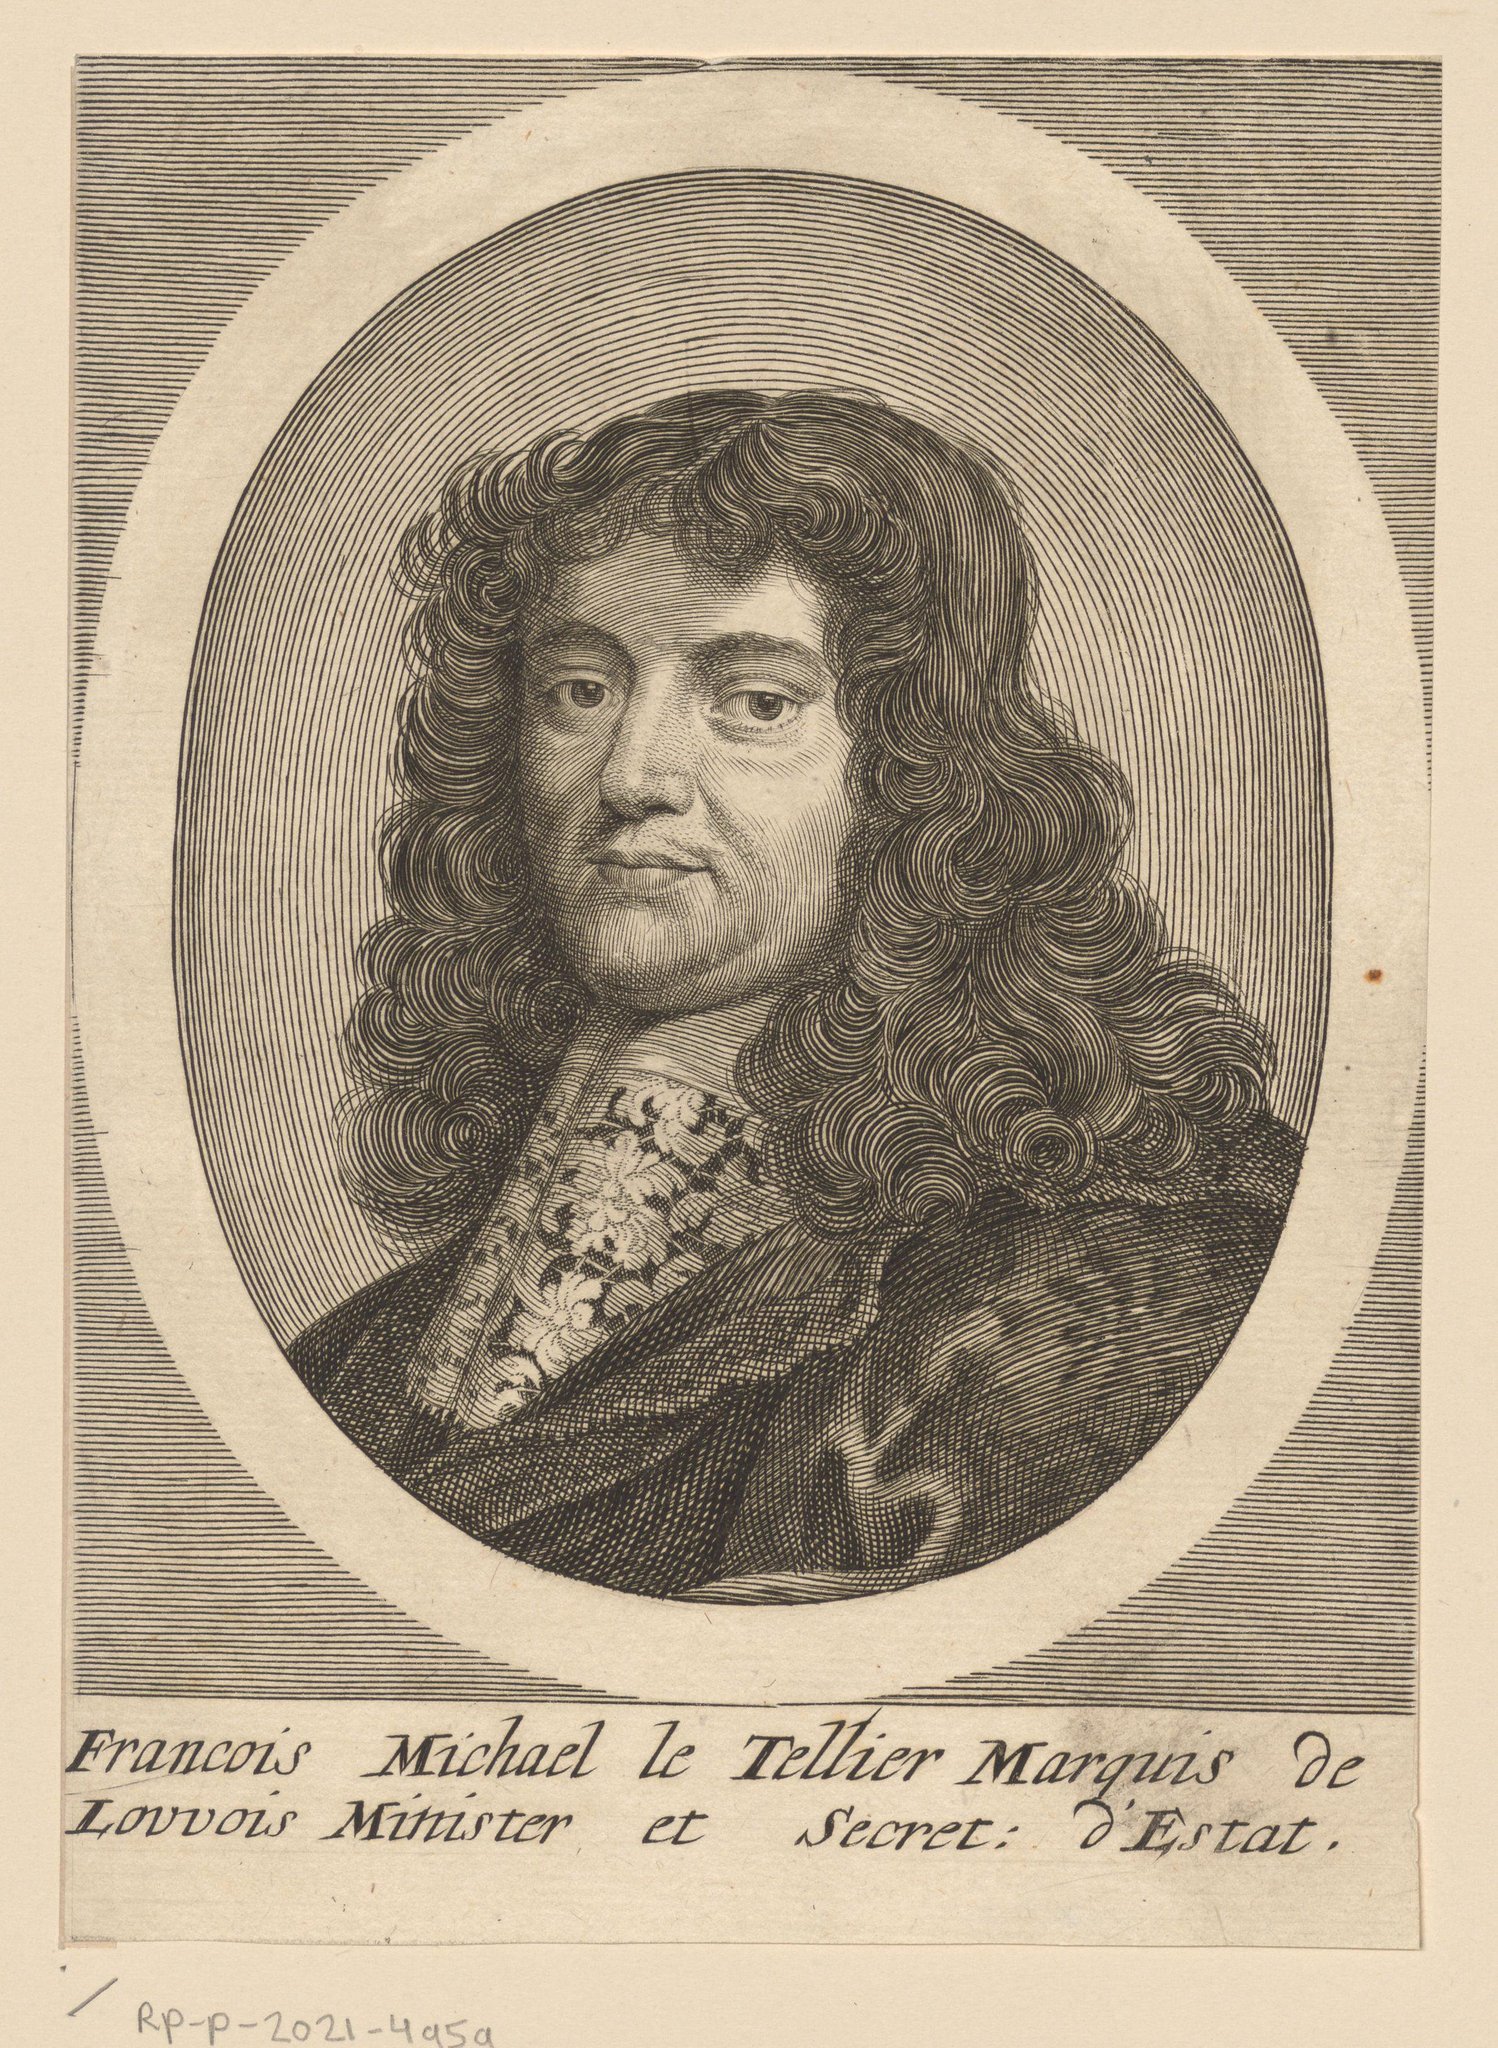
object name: print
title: Portret van François-Michel le Tellier, markies van Louvois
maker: Anonymous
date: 1683-1699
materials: paper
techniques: engraving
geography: france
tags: paris, françois-michel le tellier (markies de louvois), historical persons